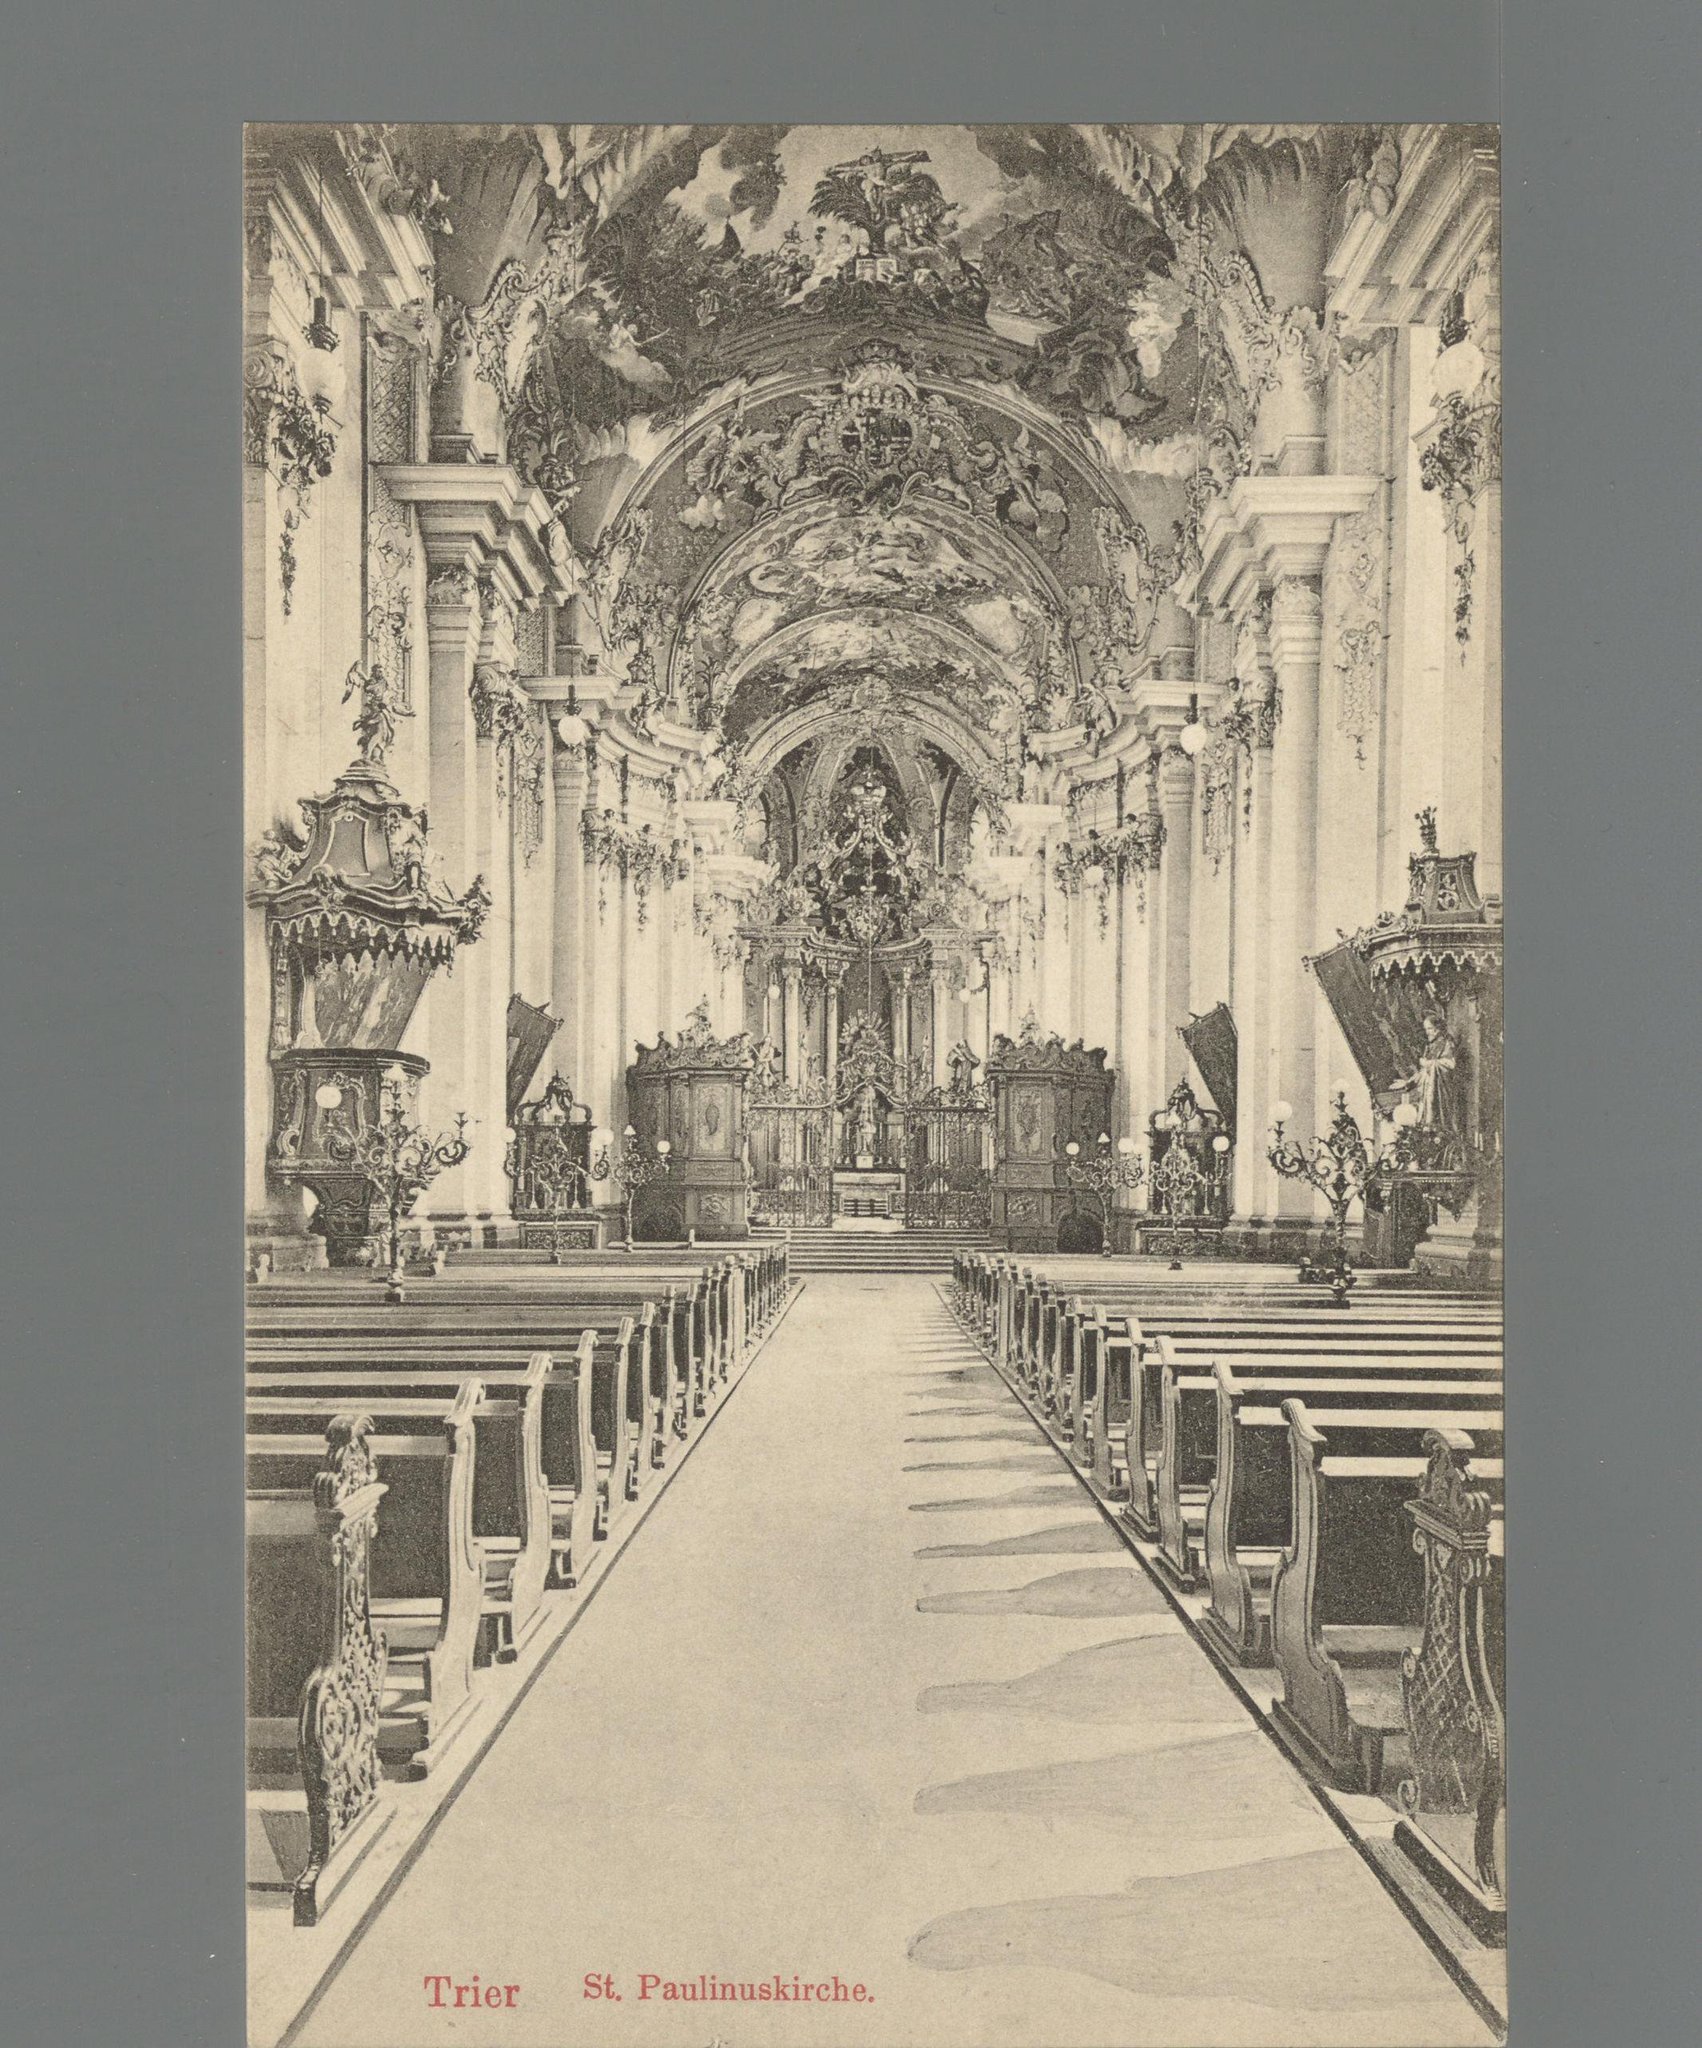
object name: photomechanical print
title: Trier. St. Paulinuskirche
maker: Anonymous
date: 1905-1930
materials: cardboard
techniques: photograph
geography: trier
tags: interior of church